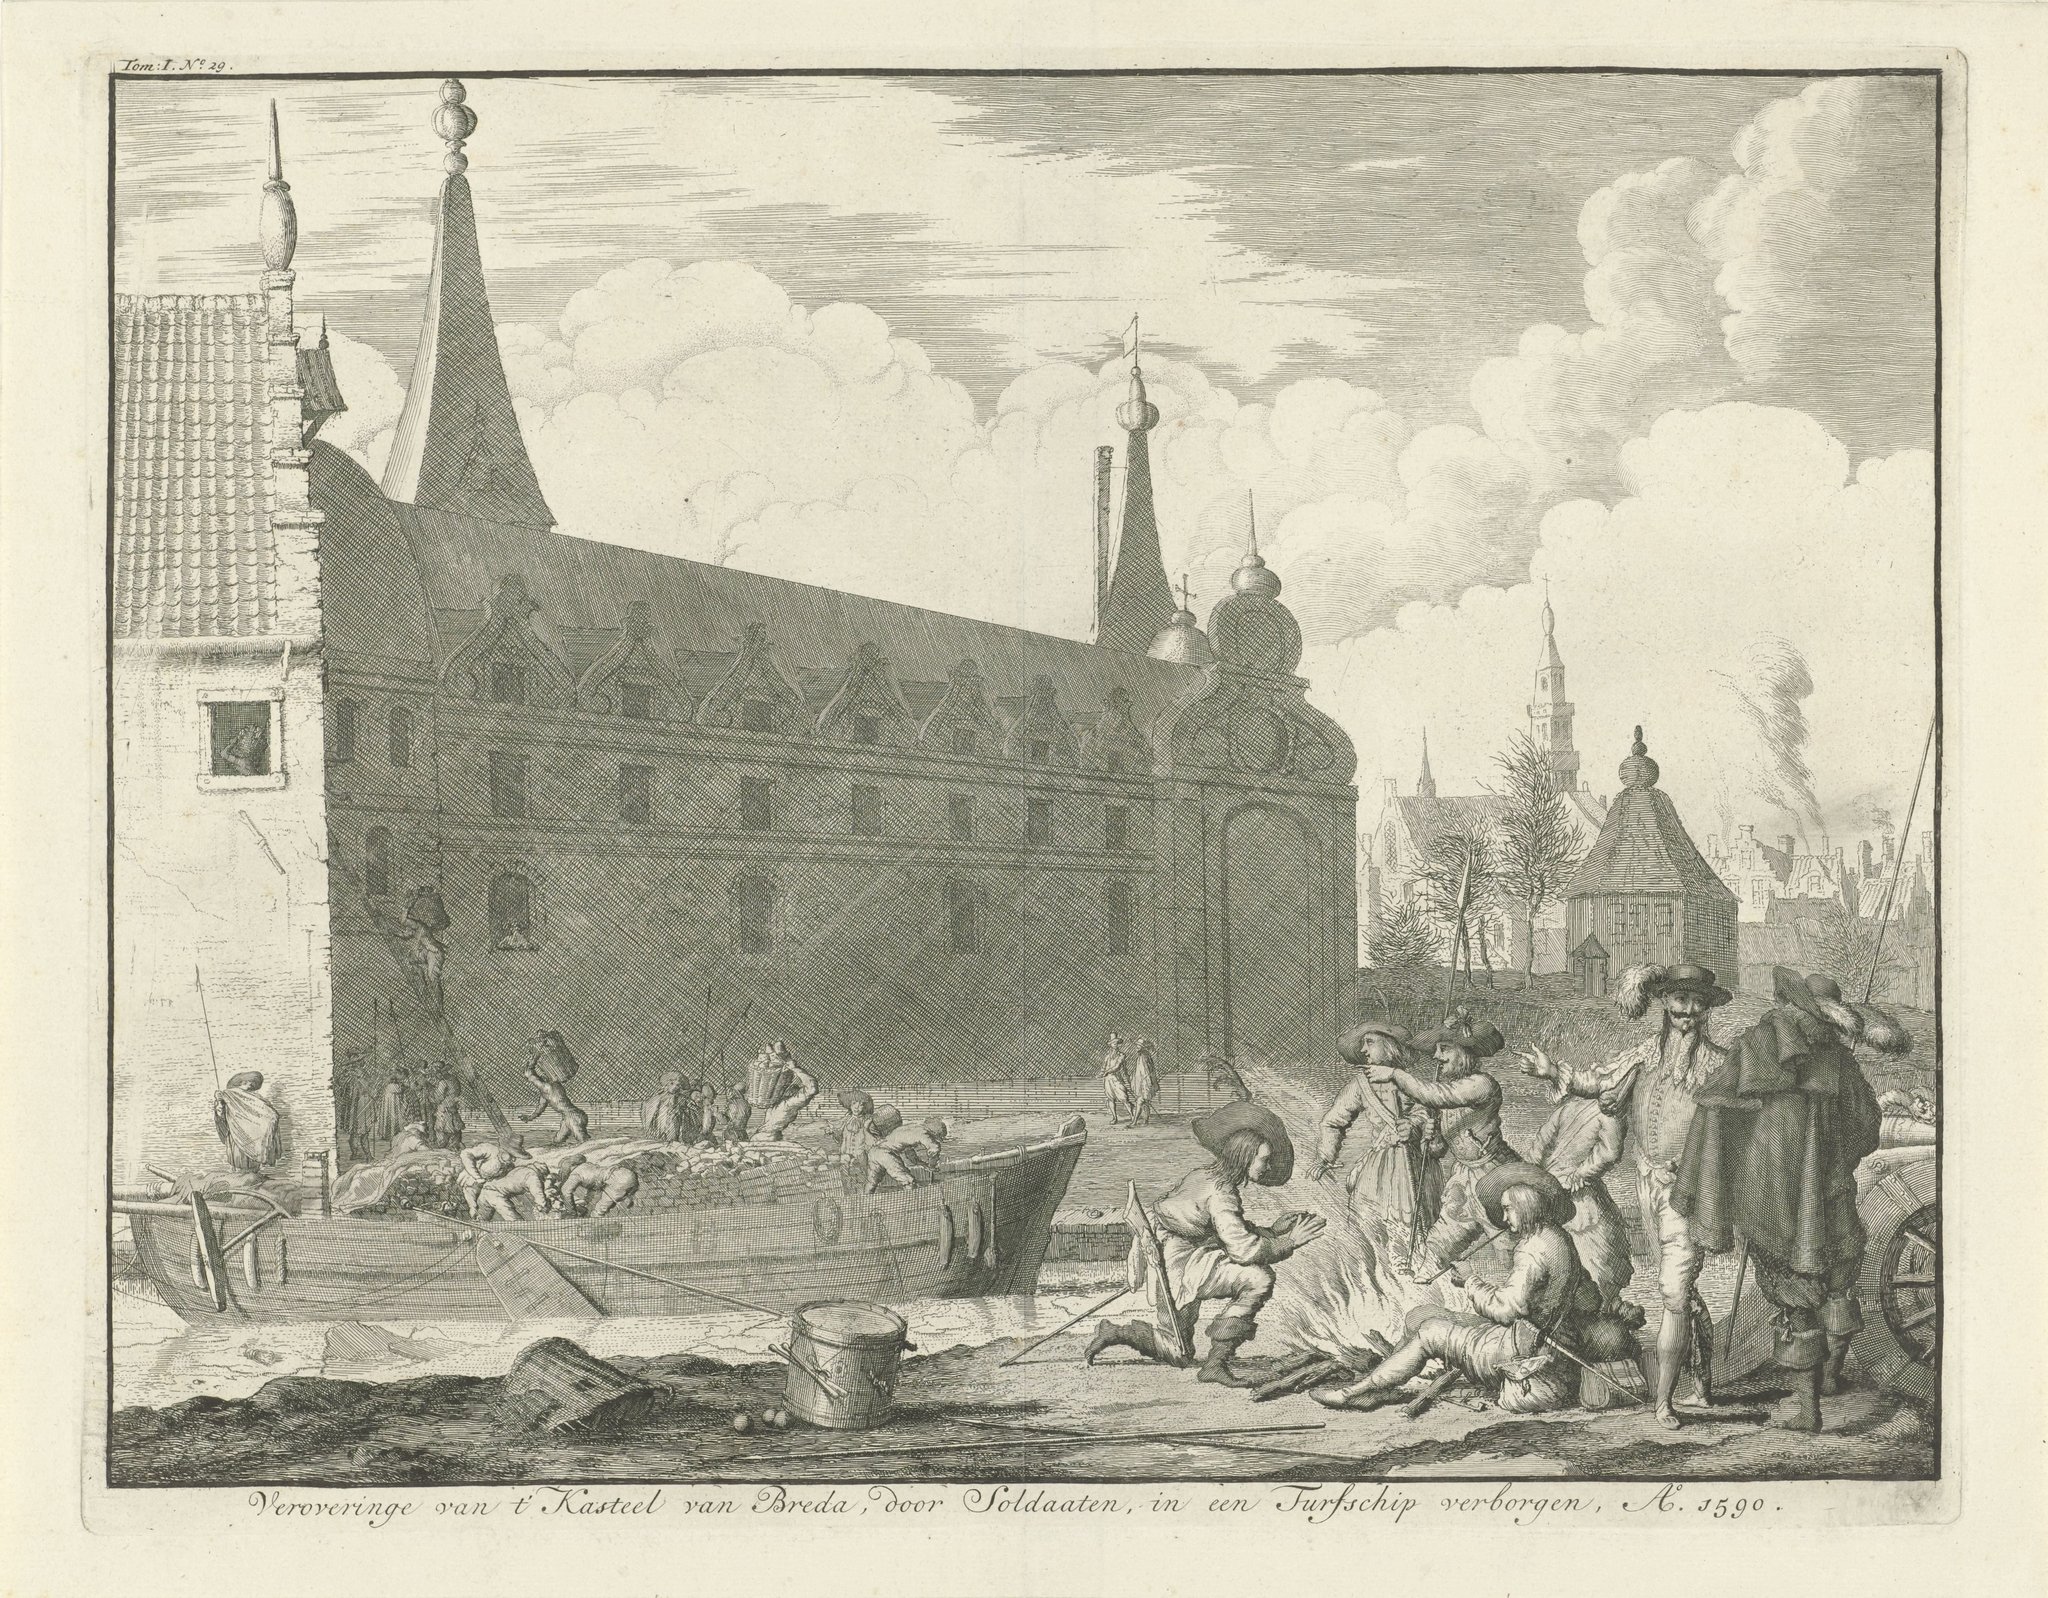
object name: print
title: Veroveringe van t' Kasteel van Breda, door Soldaten, in een Turfschip verborgen, Ao. 1590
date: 1681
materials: paper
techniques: etching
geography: amsterdam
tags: traffic and transport (+ unloading)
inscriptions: collector's mark: Lugt 2228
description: Gebruikt als illustratie in: J. le Clerc, Geschiedenissen der Vereenigde Nederlanden, sedert den aanvang van die Republyk tot op den Vrede van Utrecht in 't jaar 1713 en het Tractaat van Barriere in 't jaar 1715 gesloten, Z. Chatelain, Amsterdam 1730, 3 delen.